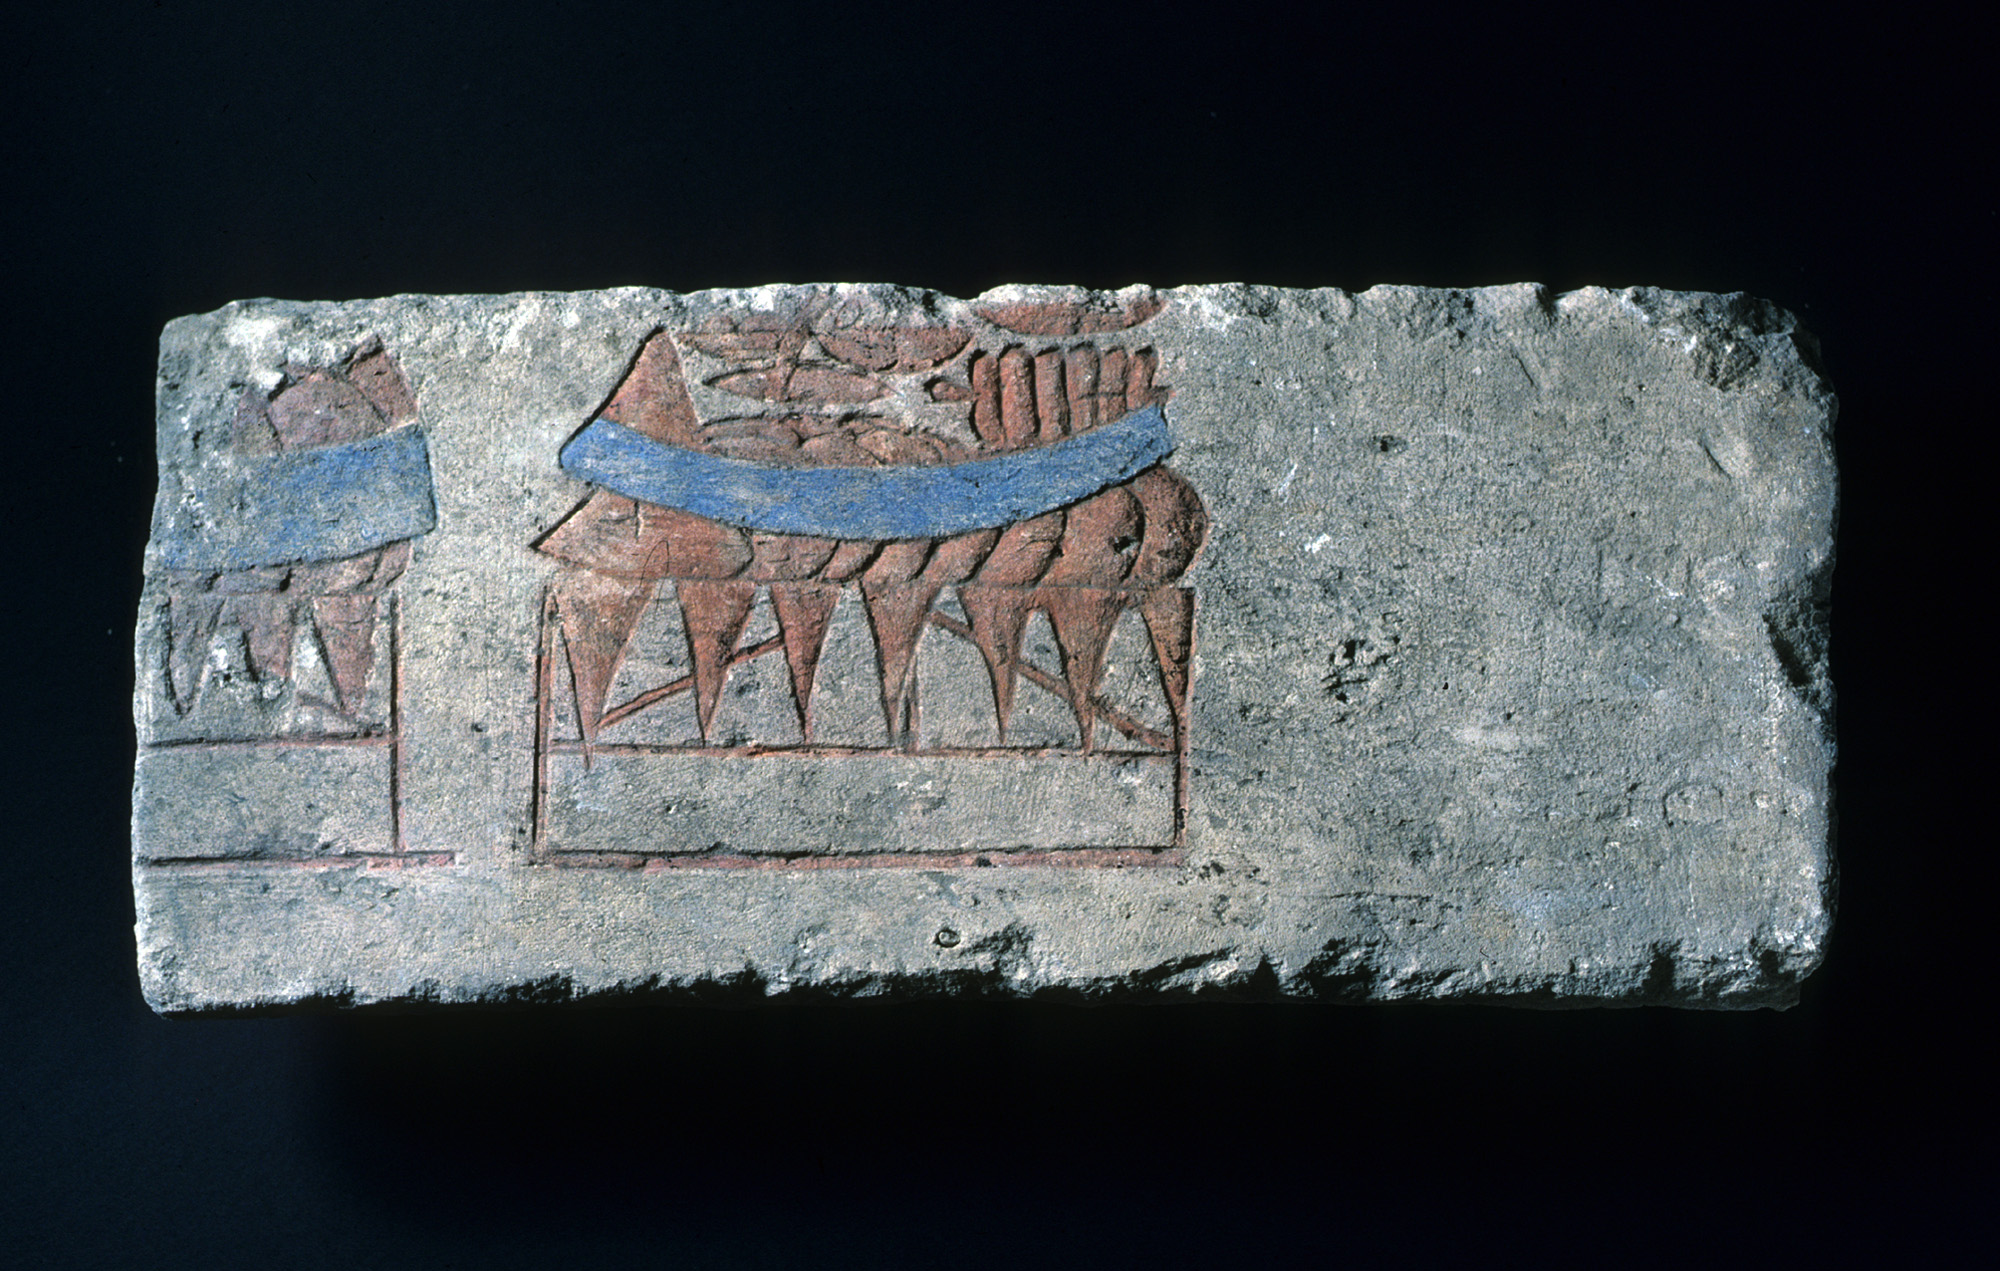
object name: talatat, offering stand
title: Relief with offering stands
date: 1353-1336 BCE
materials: limestone, paint